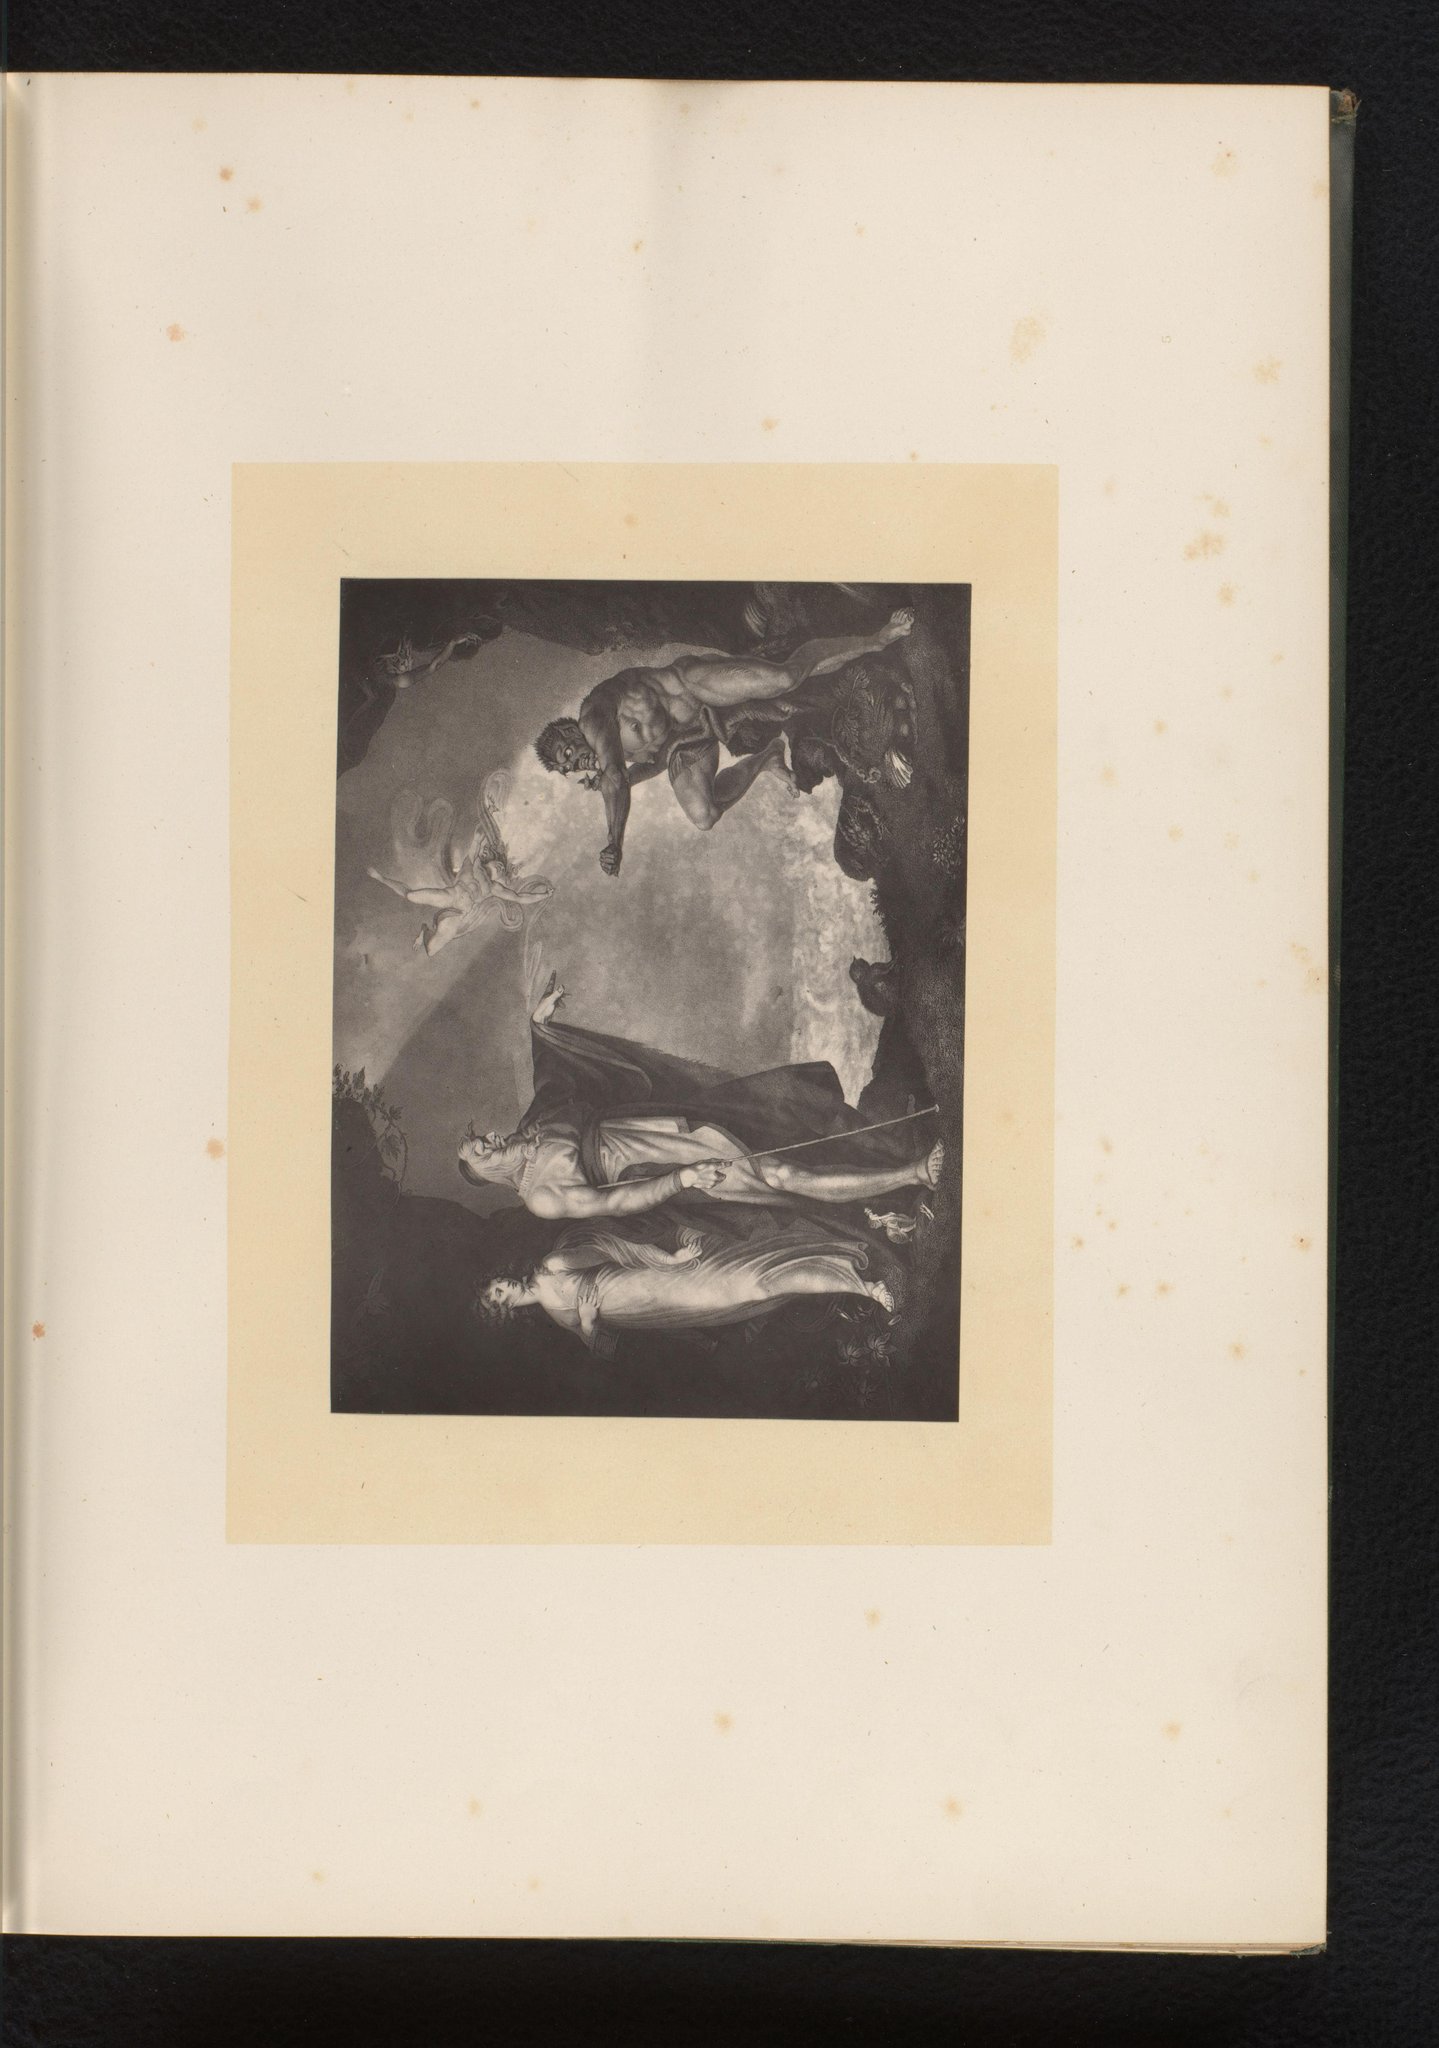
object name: reproduction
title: The Tempest, Act I, Scene 2: The Enchanted Island: Before the Cell of Prospero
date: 1874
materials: paper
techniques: woodburytype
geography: london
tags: (scenes from) specific works of literature: shakespeare, tempest